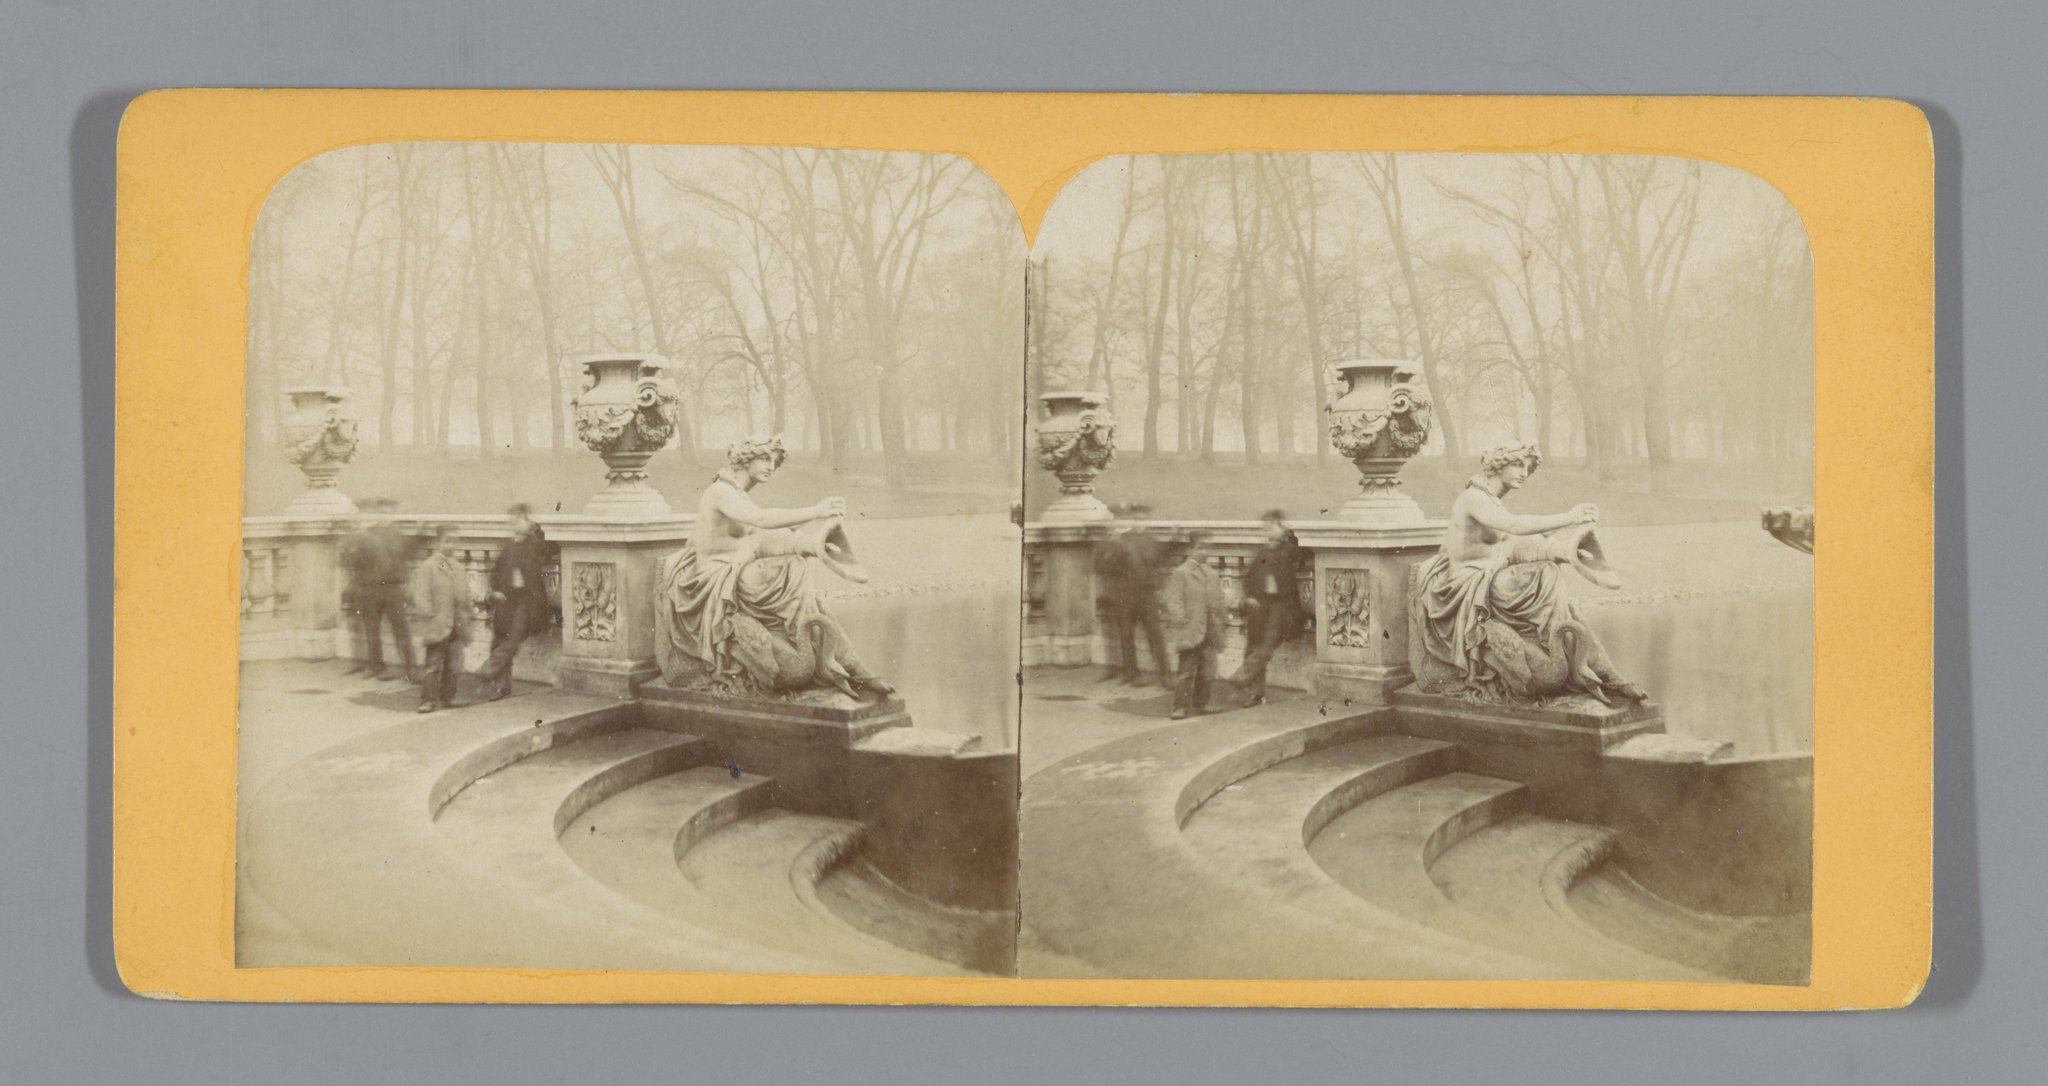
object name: stereograph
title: Bordes voor een vijver in Hyde Park in Londen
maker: Anonymous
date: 1850-1880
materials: cardboard, photographic support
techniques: albumen print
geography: hyde park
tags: sculpture, pond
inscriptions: inscription: ‘L'Abondance, Hyde Park Londres’